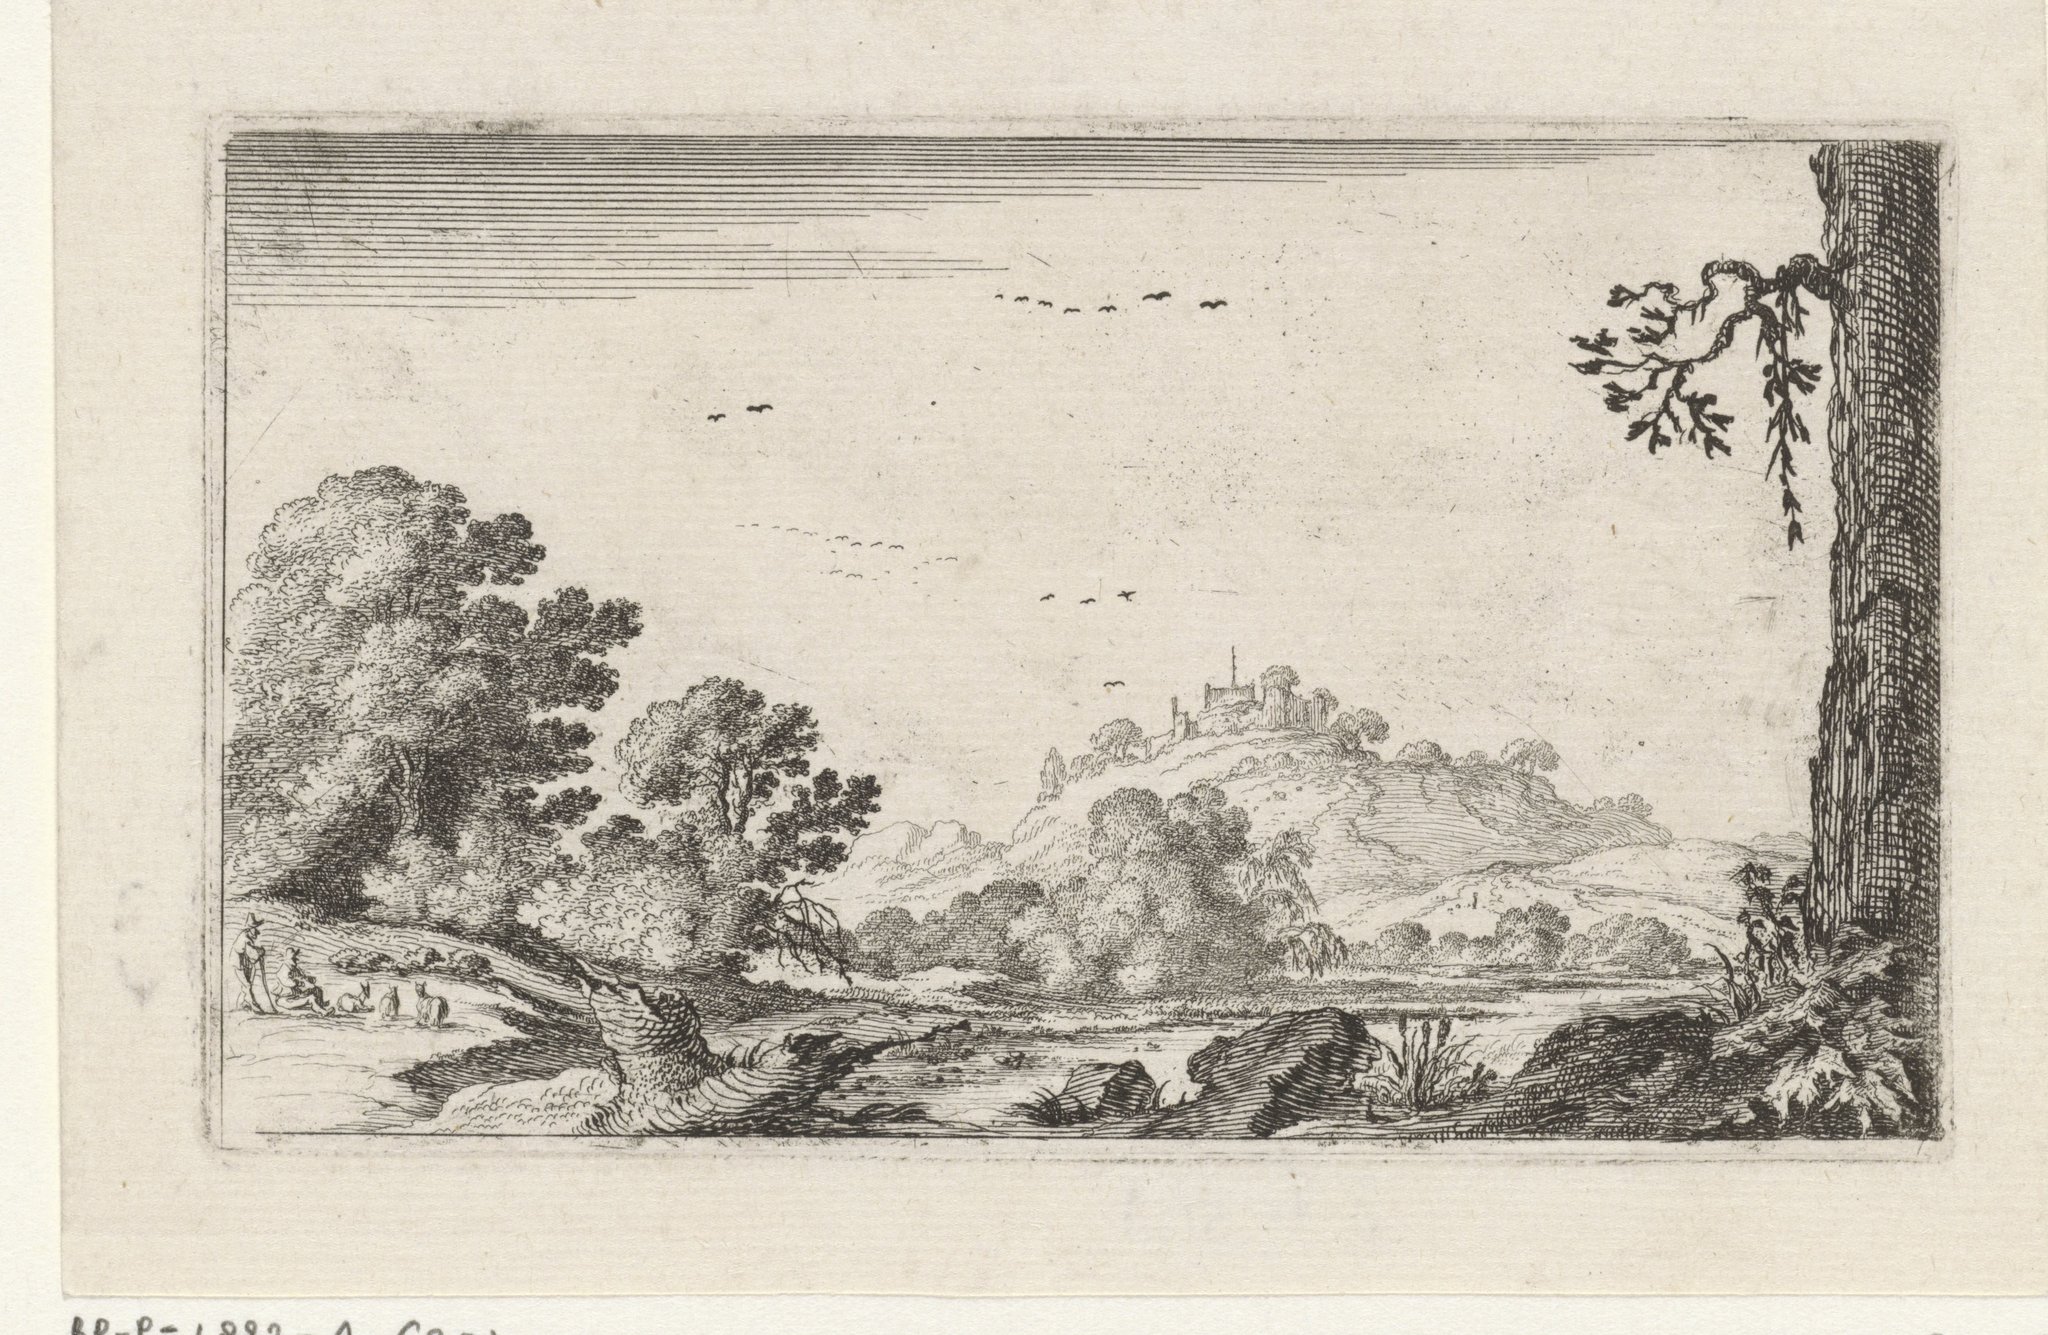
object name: print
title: Rivierlandschap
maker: gillis van scheyndel (i)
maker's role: draughtsman, print maker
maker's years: 1595-1660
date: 1605-1653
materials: paper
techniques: engraving, etching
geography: netherlands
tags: low hill country, river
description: Heuvellandschap met een rivier. Aan de waterkant enkele figuren. De prent maakt deel uit van een serie van twaalf landschappen.